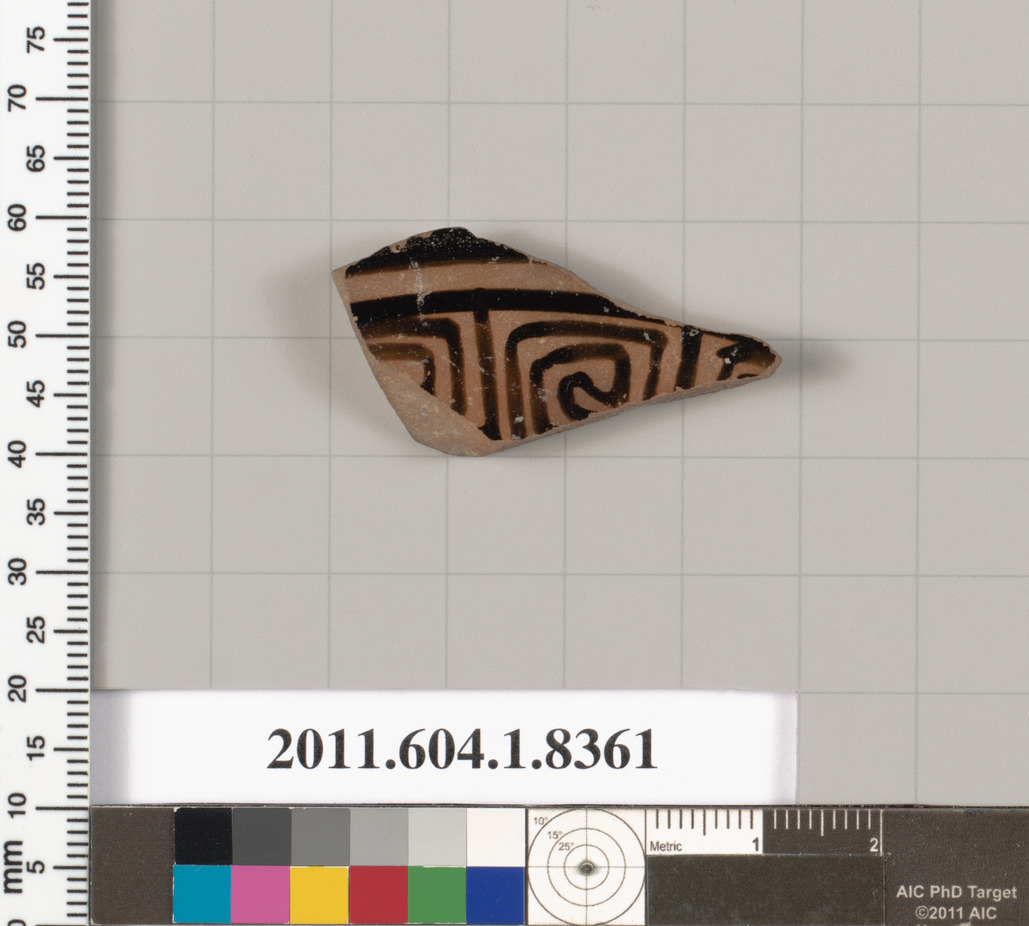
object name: kylix fragment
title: Terracotta fragment of a kylix (drinking cup)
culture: greek, attic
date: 400-351 BCE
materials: terracotta